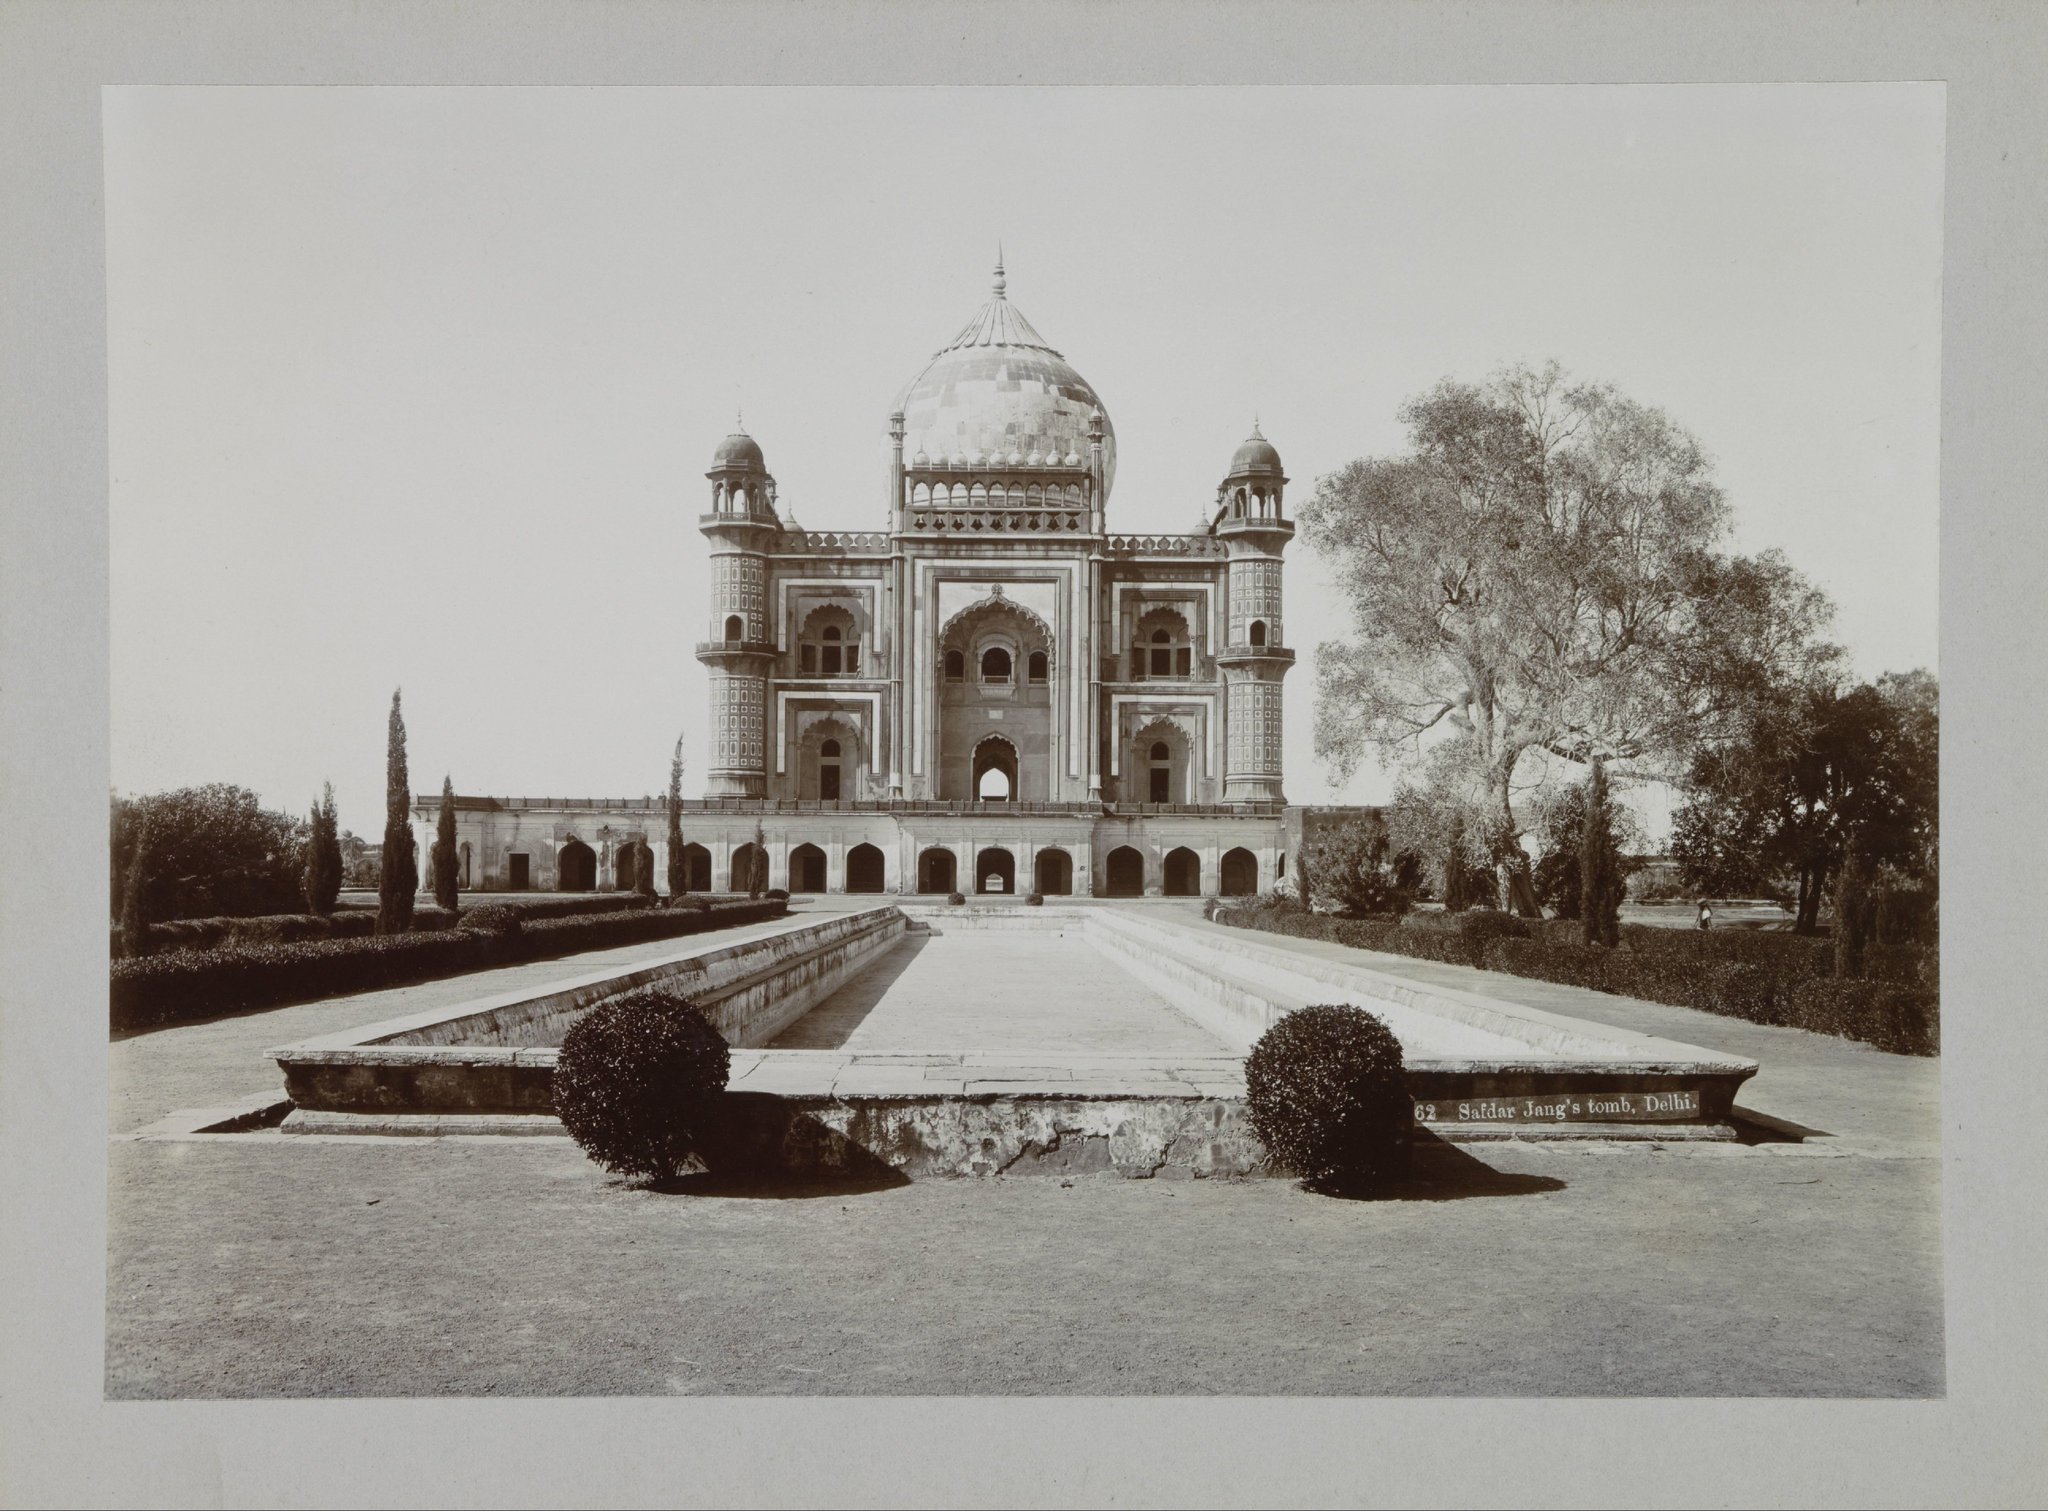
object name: photograph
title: Safdarjang's Tomb, Delhi, India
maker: Anonymous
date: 1895-1915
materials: cardboard, paper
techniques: gelatin silver print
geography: delhi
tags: delhi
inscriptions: number: ‘45.’, inscription: ‘62 Safdar Jang's tomb, Delhi.’